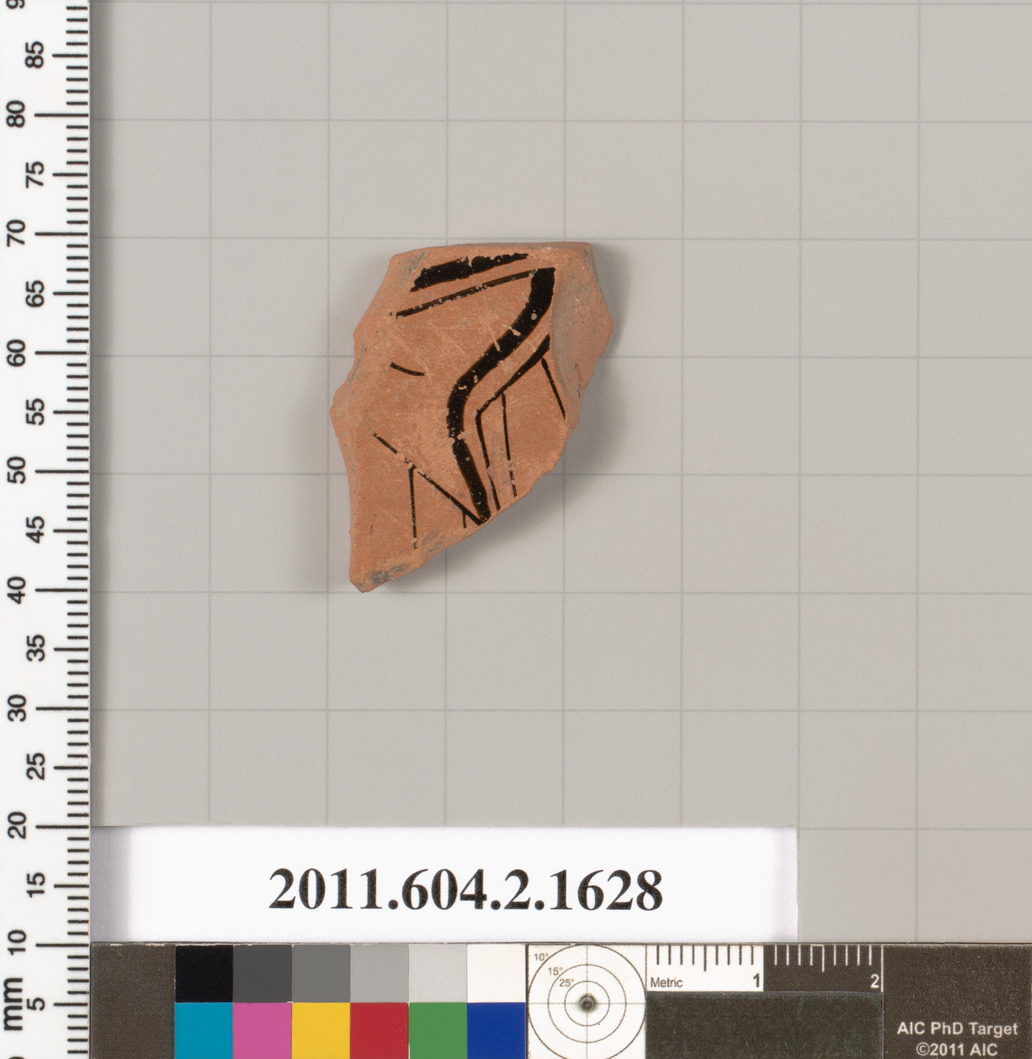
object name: skyphos fragment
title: Terracotta fragment of a skyphos (deep drinking cup)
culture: greek, attic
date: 475-451 BCE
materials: terracotta